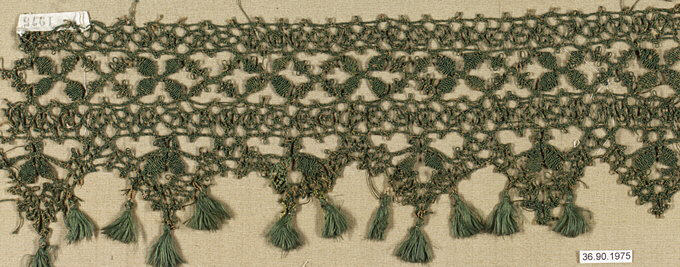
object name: piece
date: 1701-1800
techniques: lace